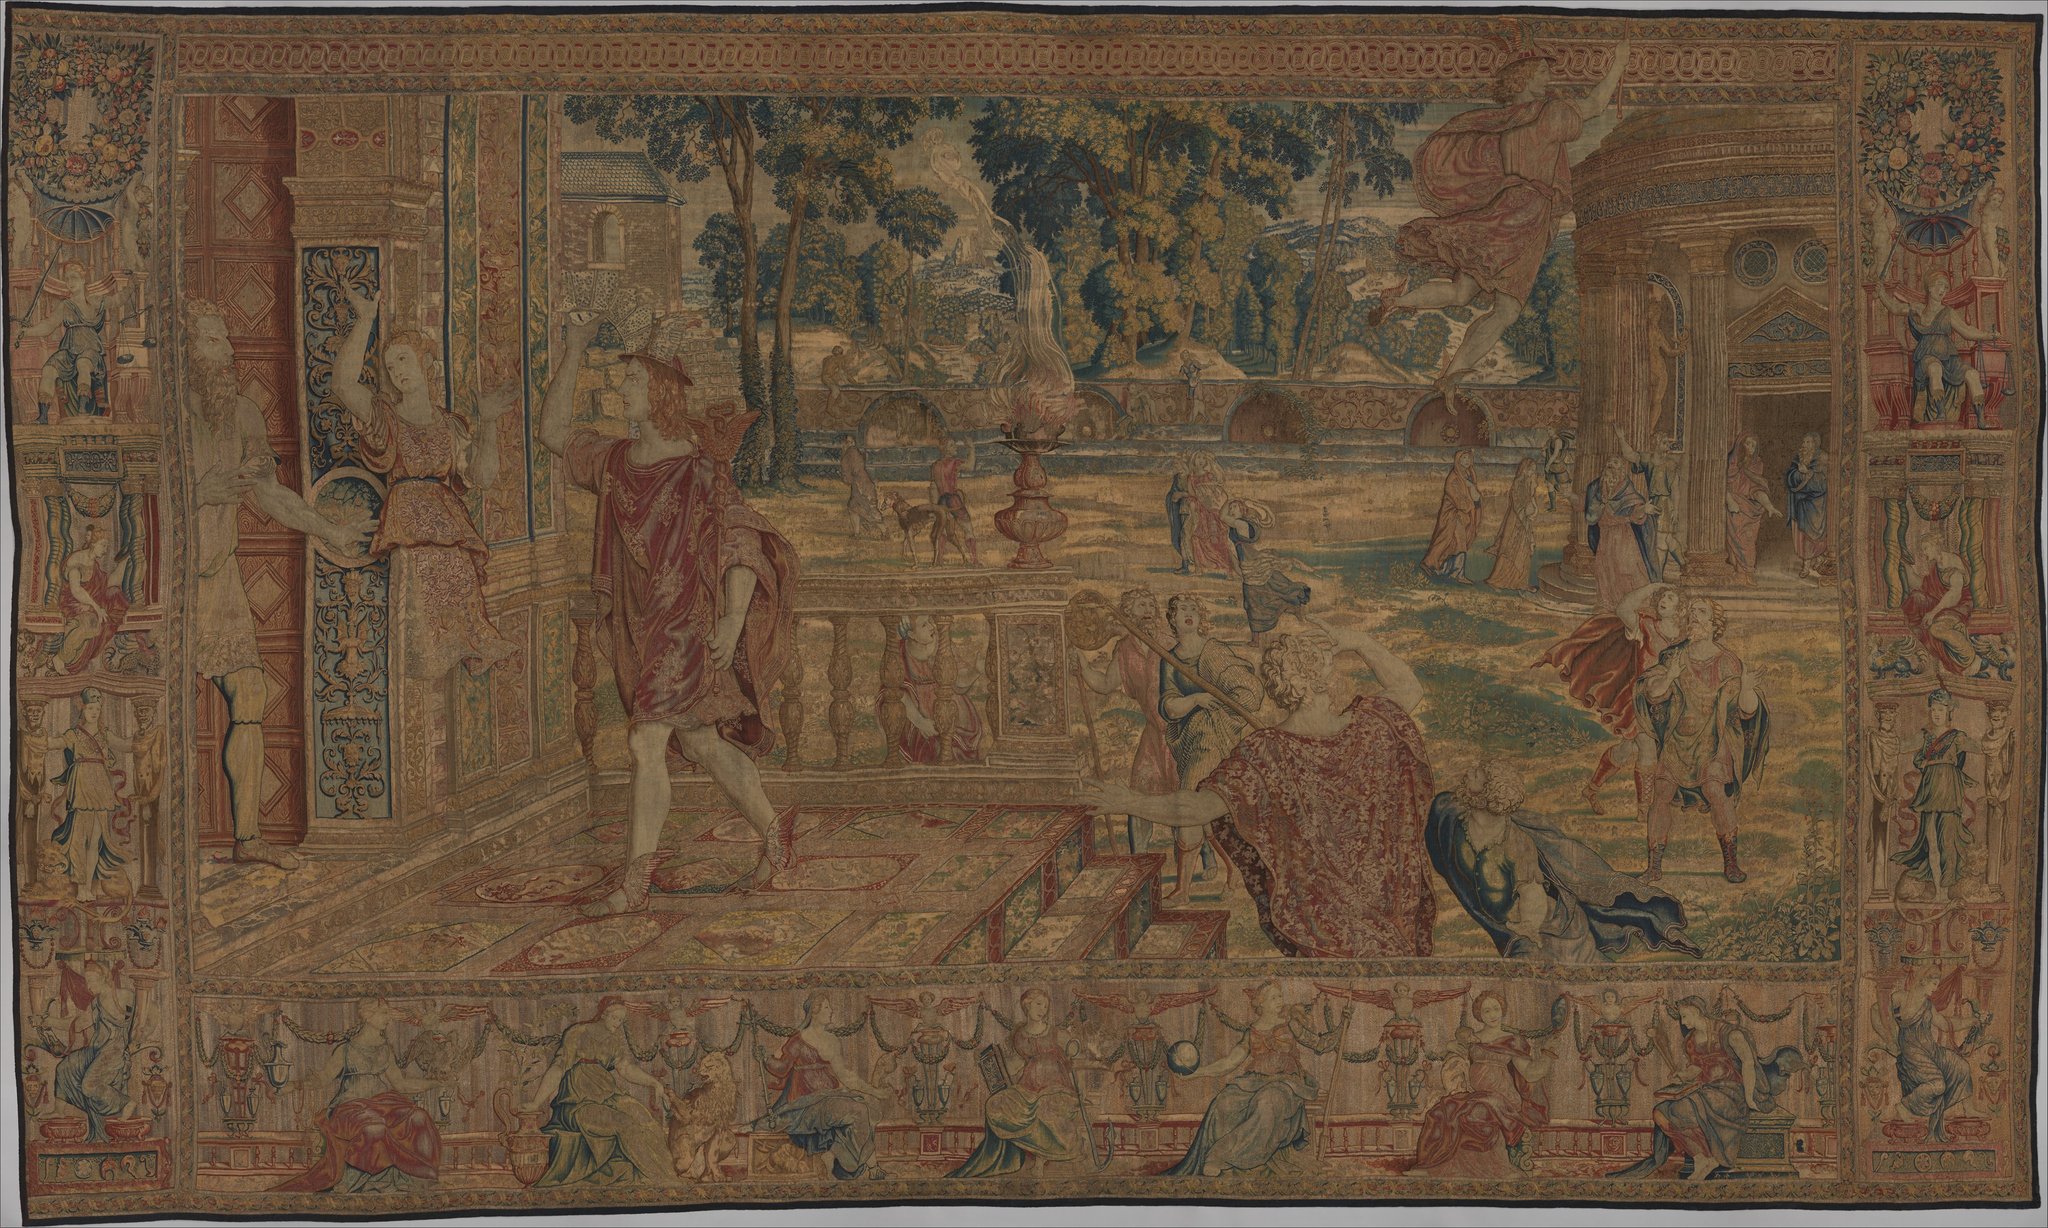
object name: tapestry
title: Mercury Changes Aglauros to Stone, from the Story of Mercury and Herse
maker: giovanni battista lodi da cremona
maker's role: designer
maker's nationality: italian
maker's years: 1540-1552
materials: metal, silk, thread, wool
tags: stairs,men,women,mercury,dogs